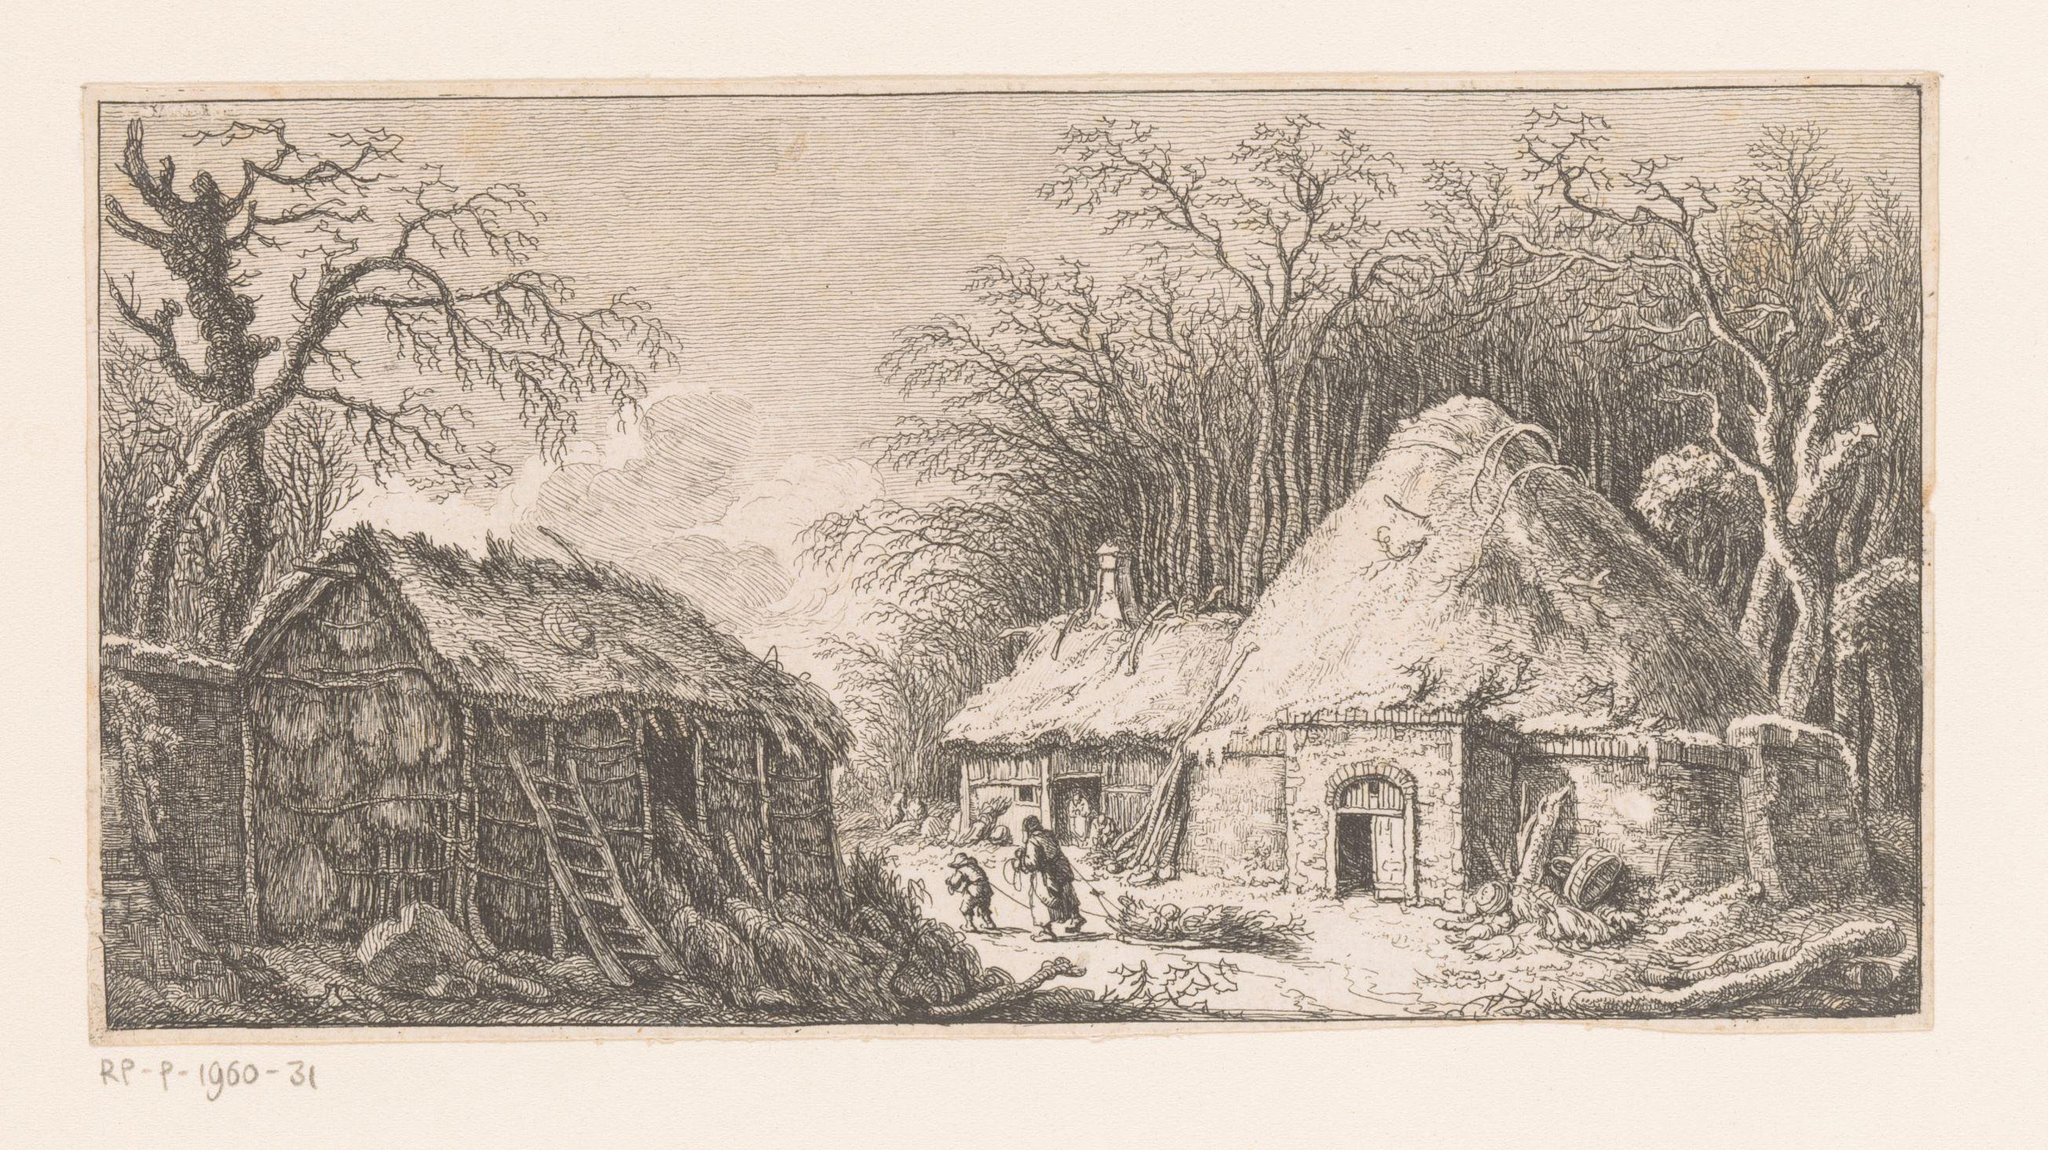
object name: print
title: Suite de paysages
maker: franz edmund weirotter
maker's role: draughtsman, painter, print maker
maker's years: 1733-1771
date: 1766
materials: paper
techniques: etching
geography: paris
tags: woodgathering, woodgatherer, farm or solitary house in landscape, mother and child(ren), woman and child(ren) (family group)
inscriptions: collector's mark: Lugt 2760, collector's mark: Lugt 2228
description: De naam van de prentmaker linksboven lijkt van het papier af te zijn gekrast.